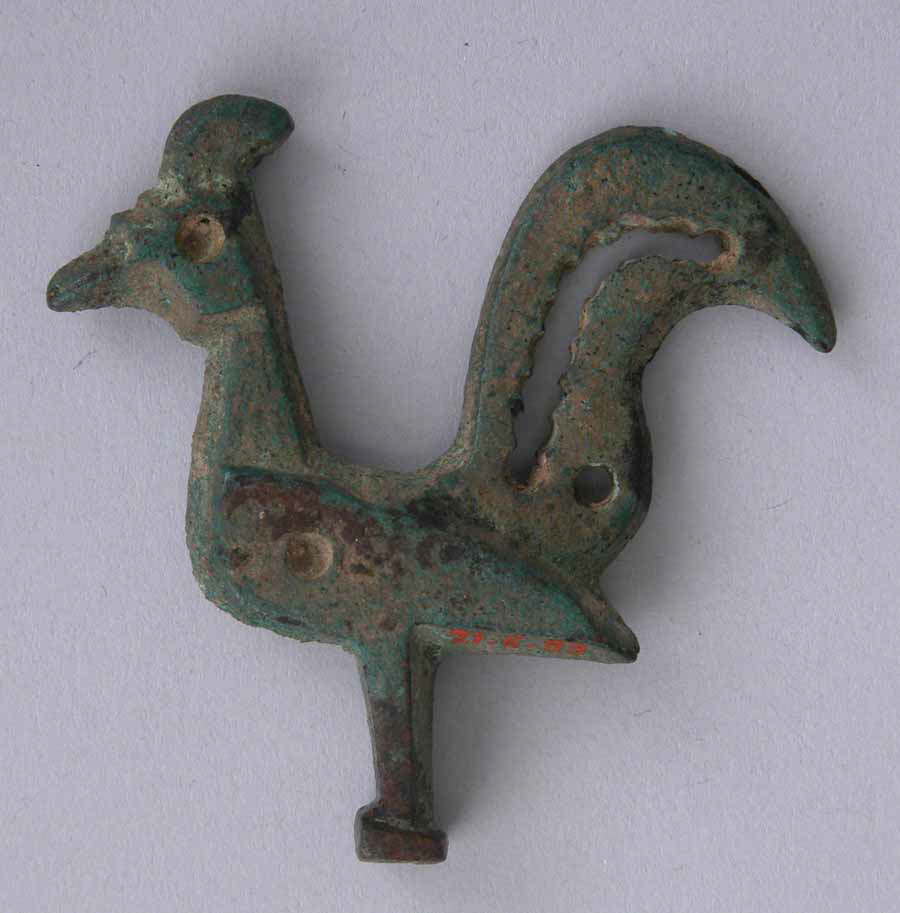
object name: figure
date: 201-1200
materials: bronze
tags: birds